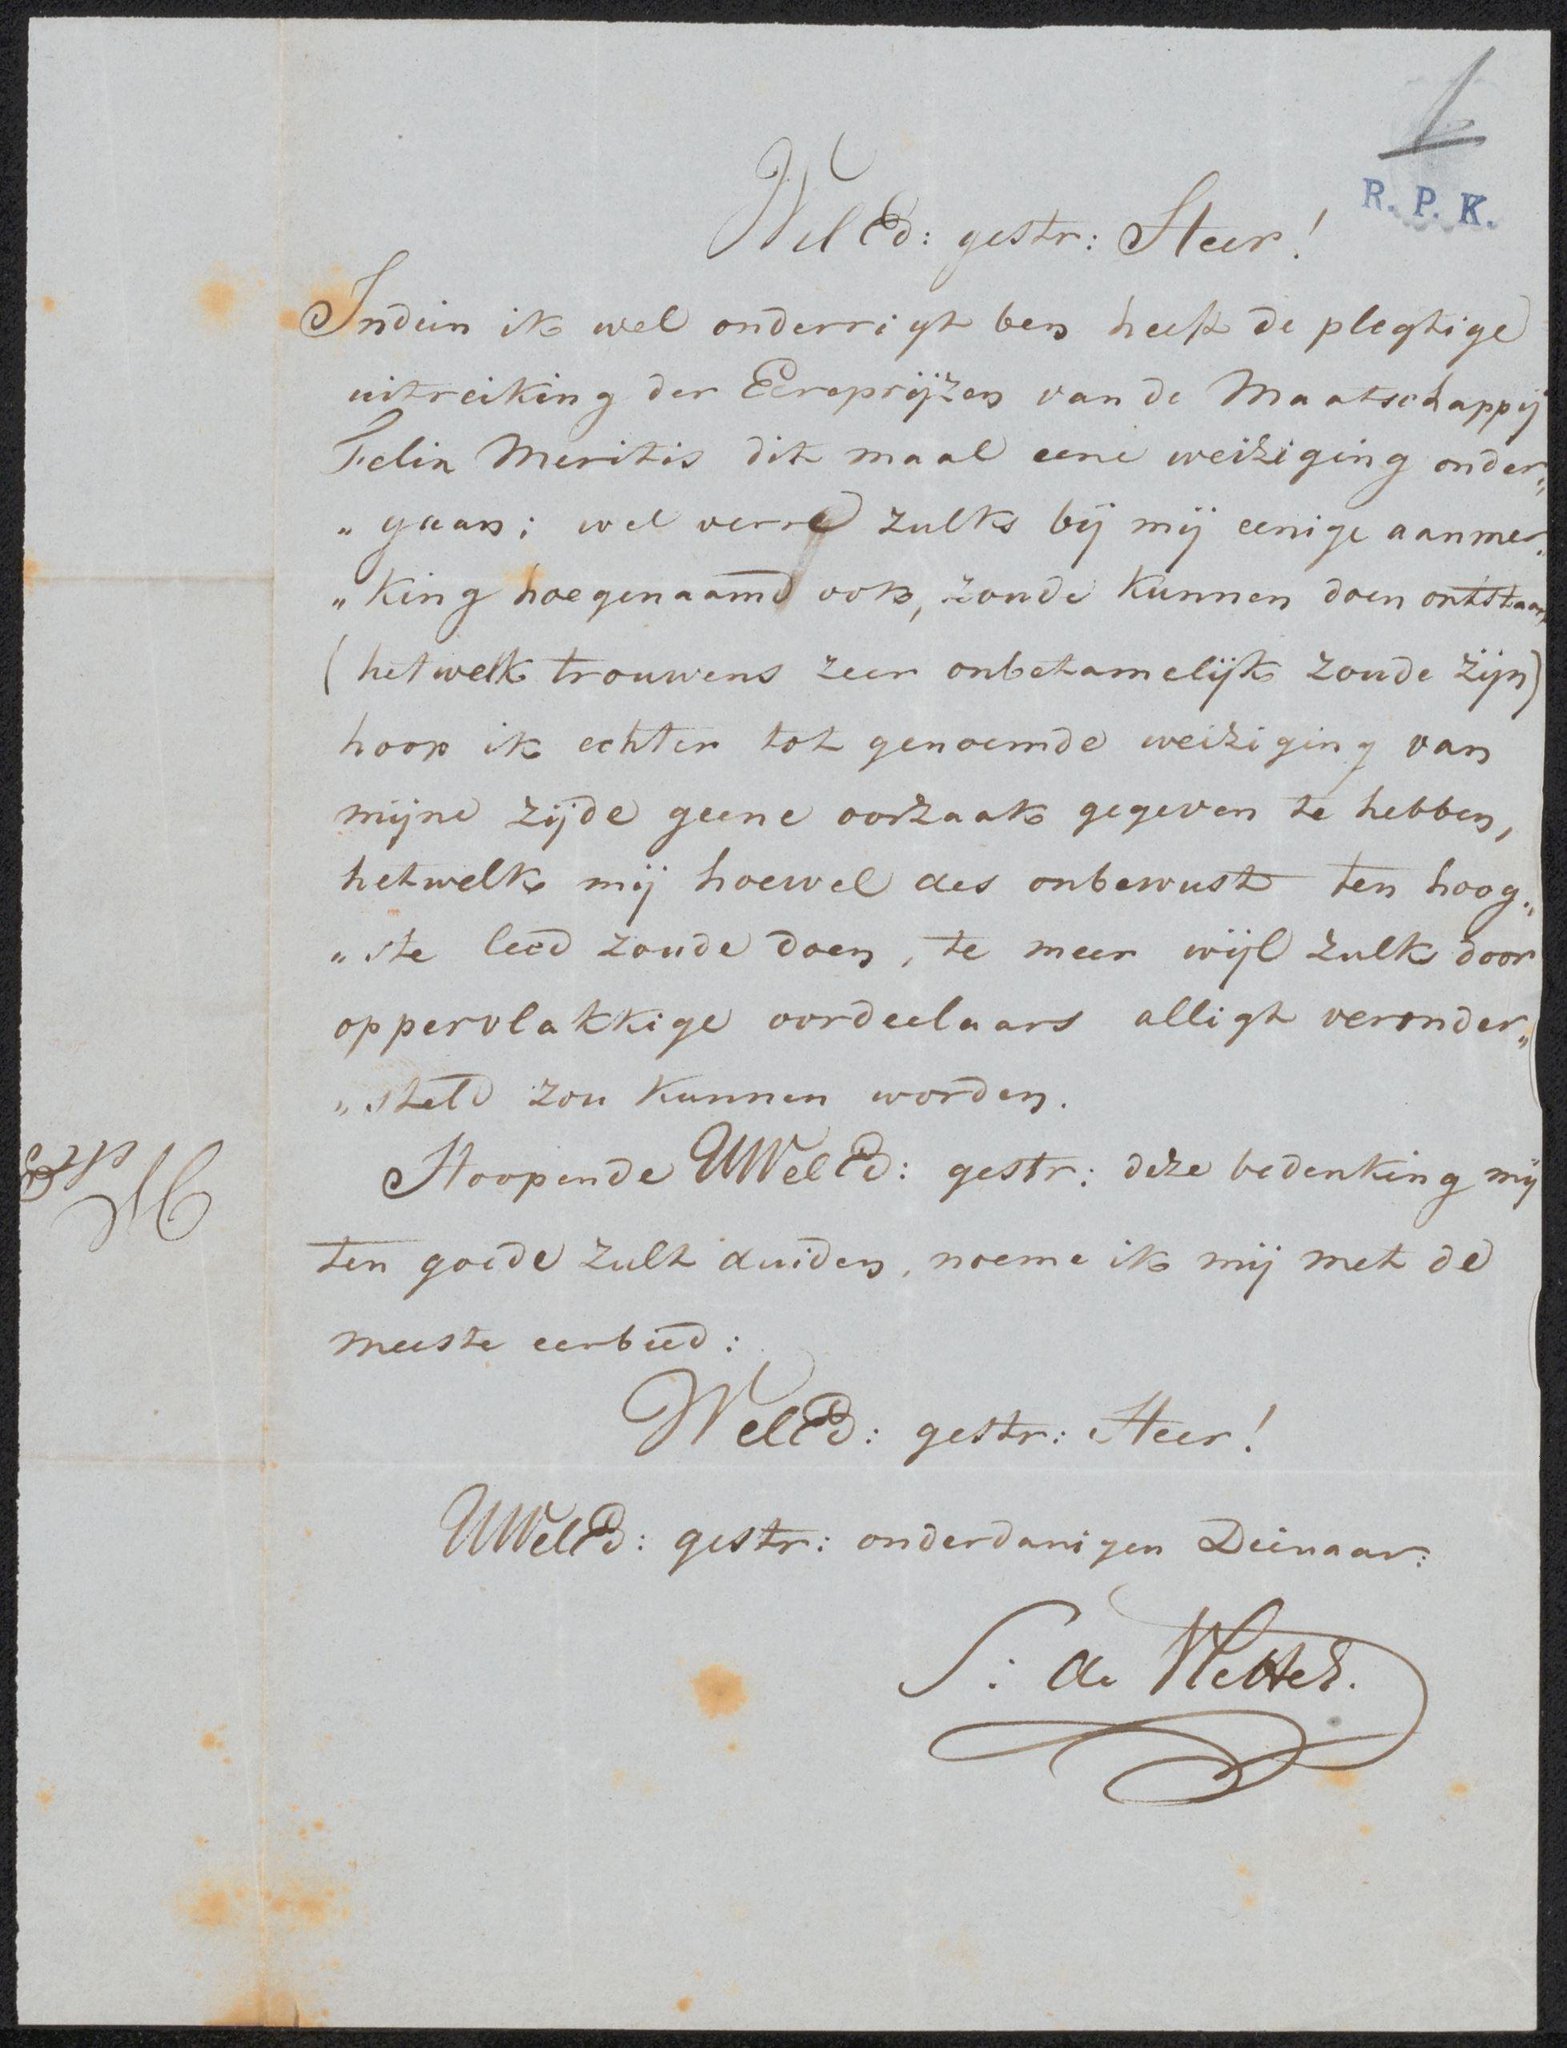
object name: letter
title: Brief aan anoniem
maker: samuel de vletter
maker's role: draughtsman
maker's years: 1816-1844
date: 1826-1844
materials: ink, paper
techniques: pen, writing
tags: distribution of awards ~ art contest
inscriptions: collector's mark: Lugt 2233